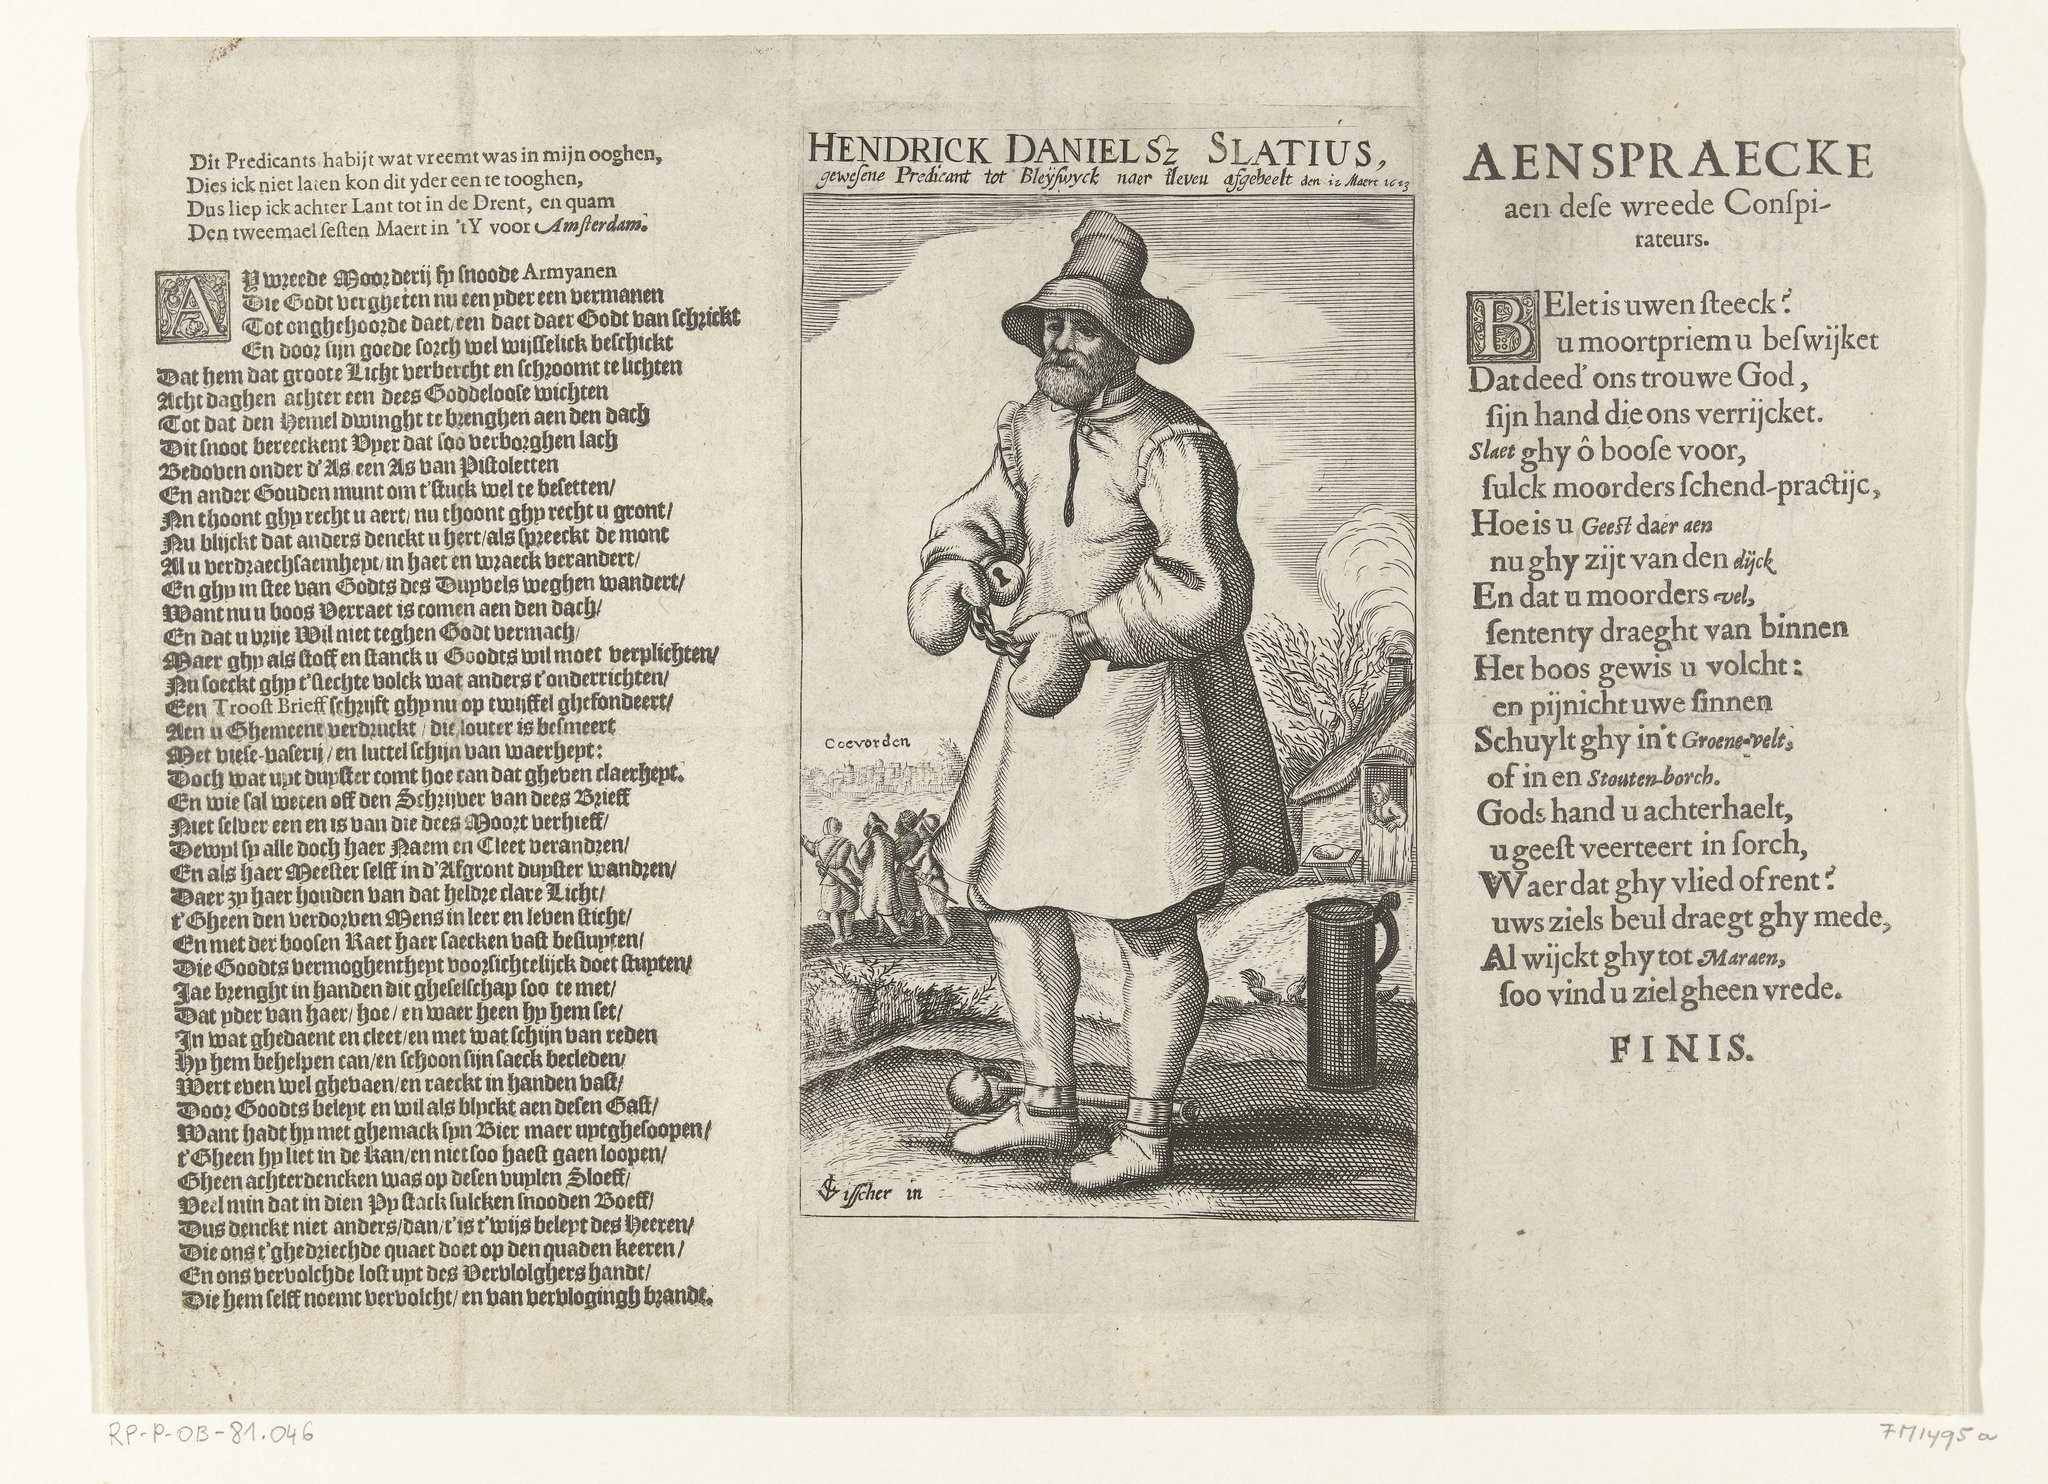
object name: print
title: Hendrick Danielsz Slatius, gewesene Predicant tot Bleijswyck naer t'leven afgebeelt den 12. Maert 1623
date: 1623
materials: paper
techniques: engraving, letterpress printing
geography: northern netherlands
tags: maurice (prince of orange), arrest (of criminal)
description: Portret van Henricus Slatius, één van de samenzweerders tegen Maurits, met hand- en voetboeien, in de kleding waarin hij werd gevangengenomen, 1623. Rechts op de grond de bierkan, op de achtergrond Coevorden. Links van de plaat een vers, rechts de 'Aenspraecke aen dese wreede Conspirateurs', in het Nederlands.